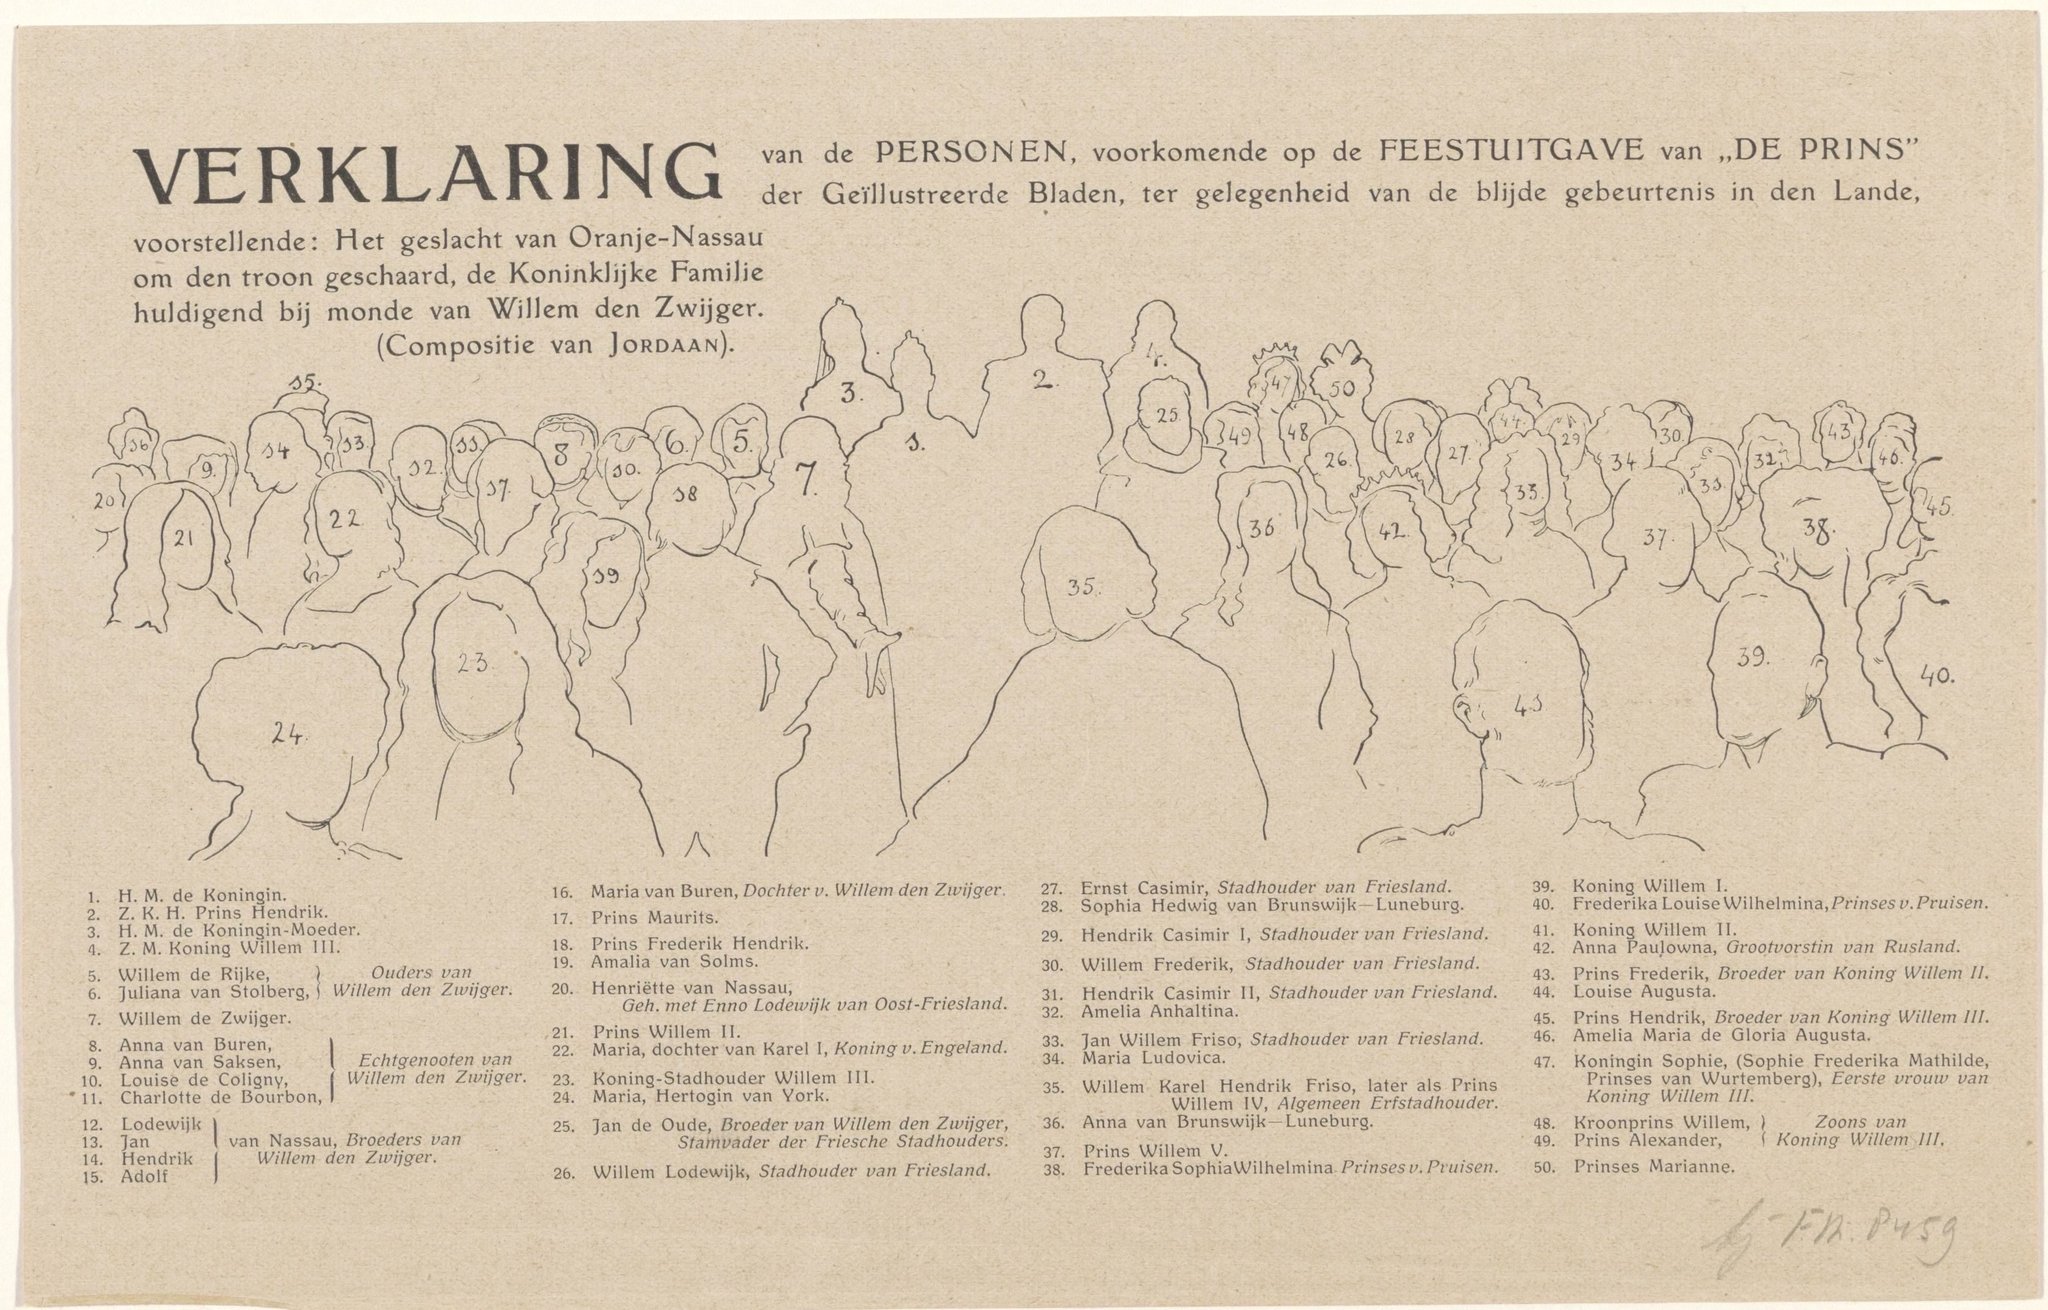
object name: reproduction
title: Verklaring van de Personen, voorkomende op de Feestuitgave (...) ter gelegenheid van de blijde gebuertenis in den Lande, voorstellende: Het geslacht van Oranje-Nassau om den troon geschaard (...)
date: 1909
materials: paper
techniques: printing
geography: netherlands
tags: wilhelmina of the netherlands, the hague, hendrik (prins der nederlanden (1876-1934)), juliana of the netherlands, family group, especially parents with their child(ren), mother and baby or young child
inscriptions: collector's mark: Lugt 2228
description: Verklaring behorende bij de feestuitgave van "De Prins" der Geïllustreerde Bladen ter gelegenheid van de geboorte van prinses Juliana op 20 april 1909. Sleutel met de namen van de afgebeelde leden van het geslacht Oranje-Nassau bijeen in een zaal waarbij Willem van Oranje namens allen een groet brengt aan Koningin Wilhelmina en Prins Hendrik. Onderaan de legenda met de nummers 1-50.